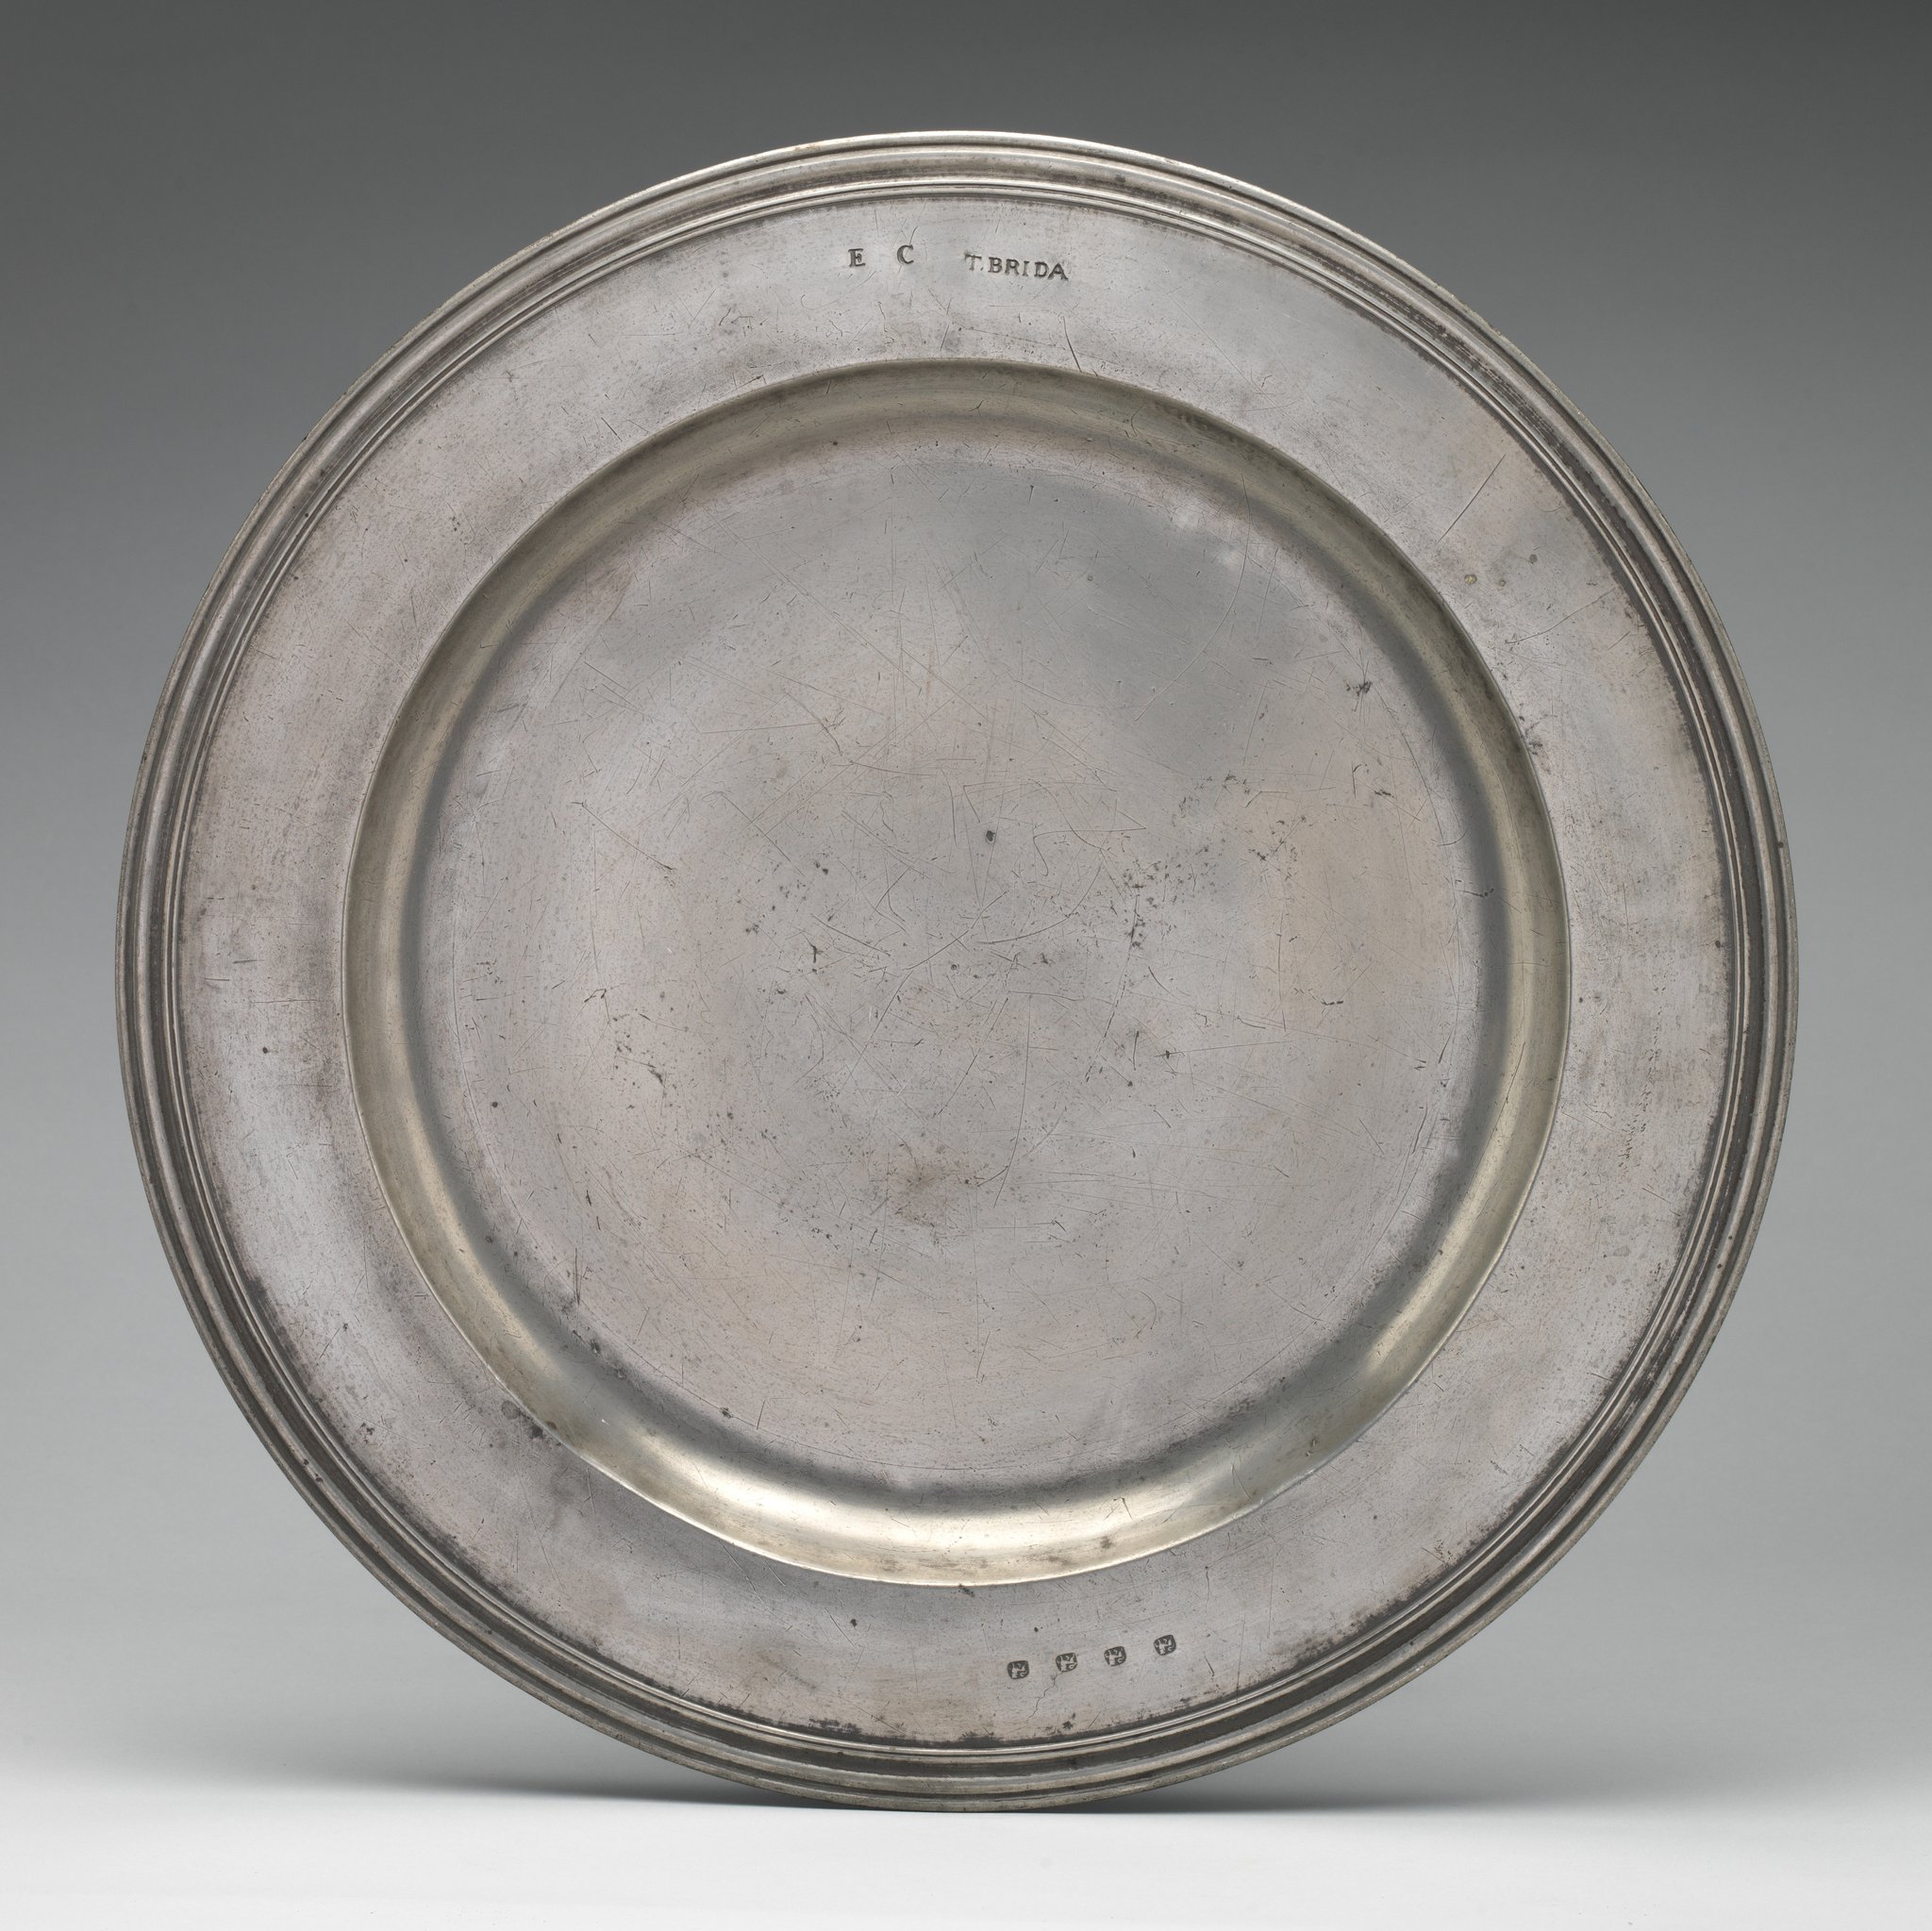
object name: charger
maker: benjamin blackwell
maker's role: maker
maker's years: 1675-1775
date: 1701-1750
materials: pewter